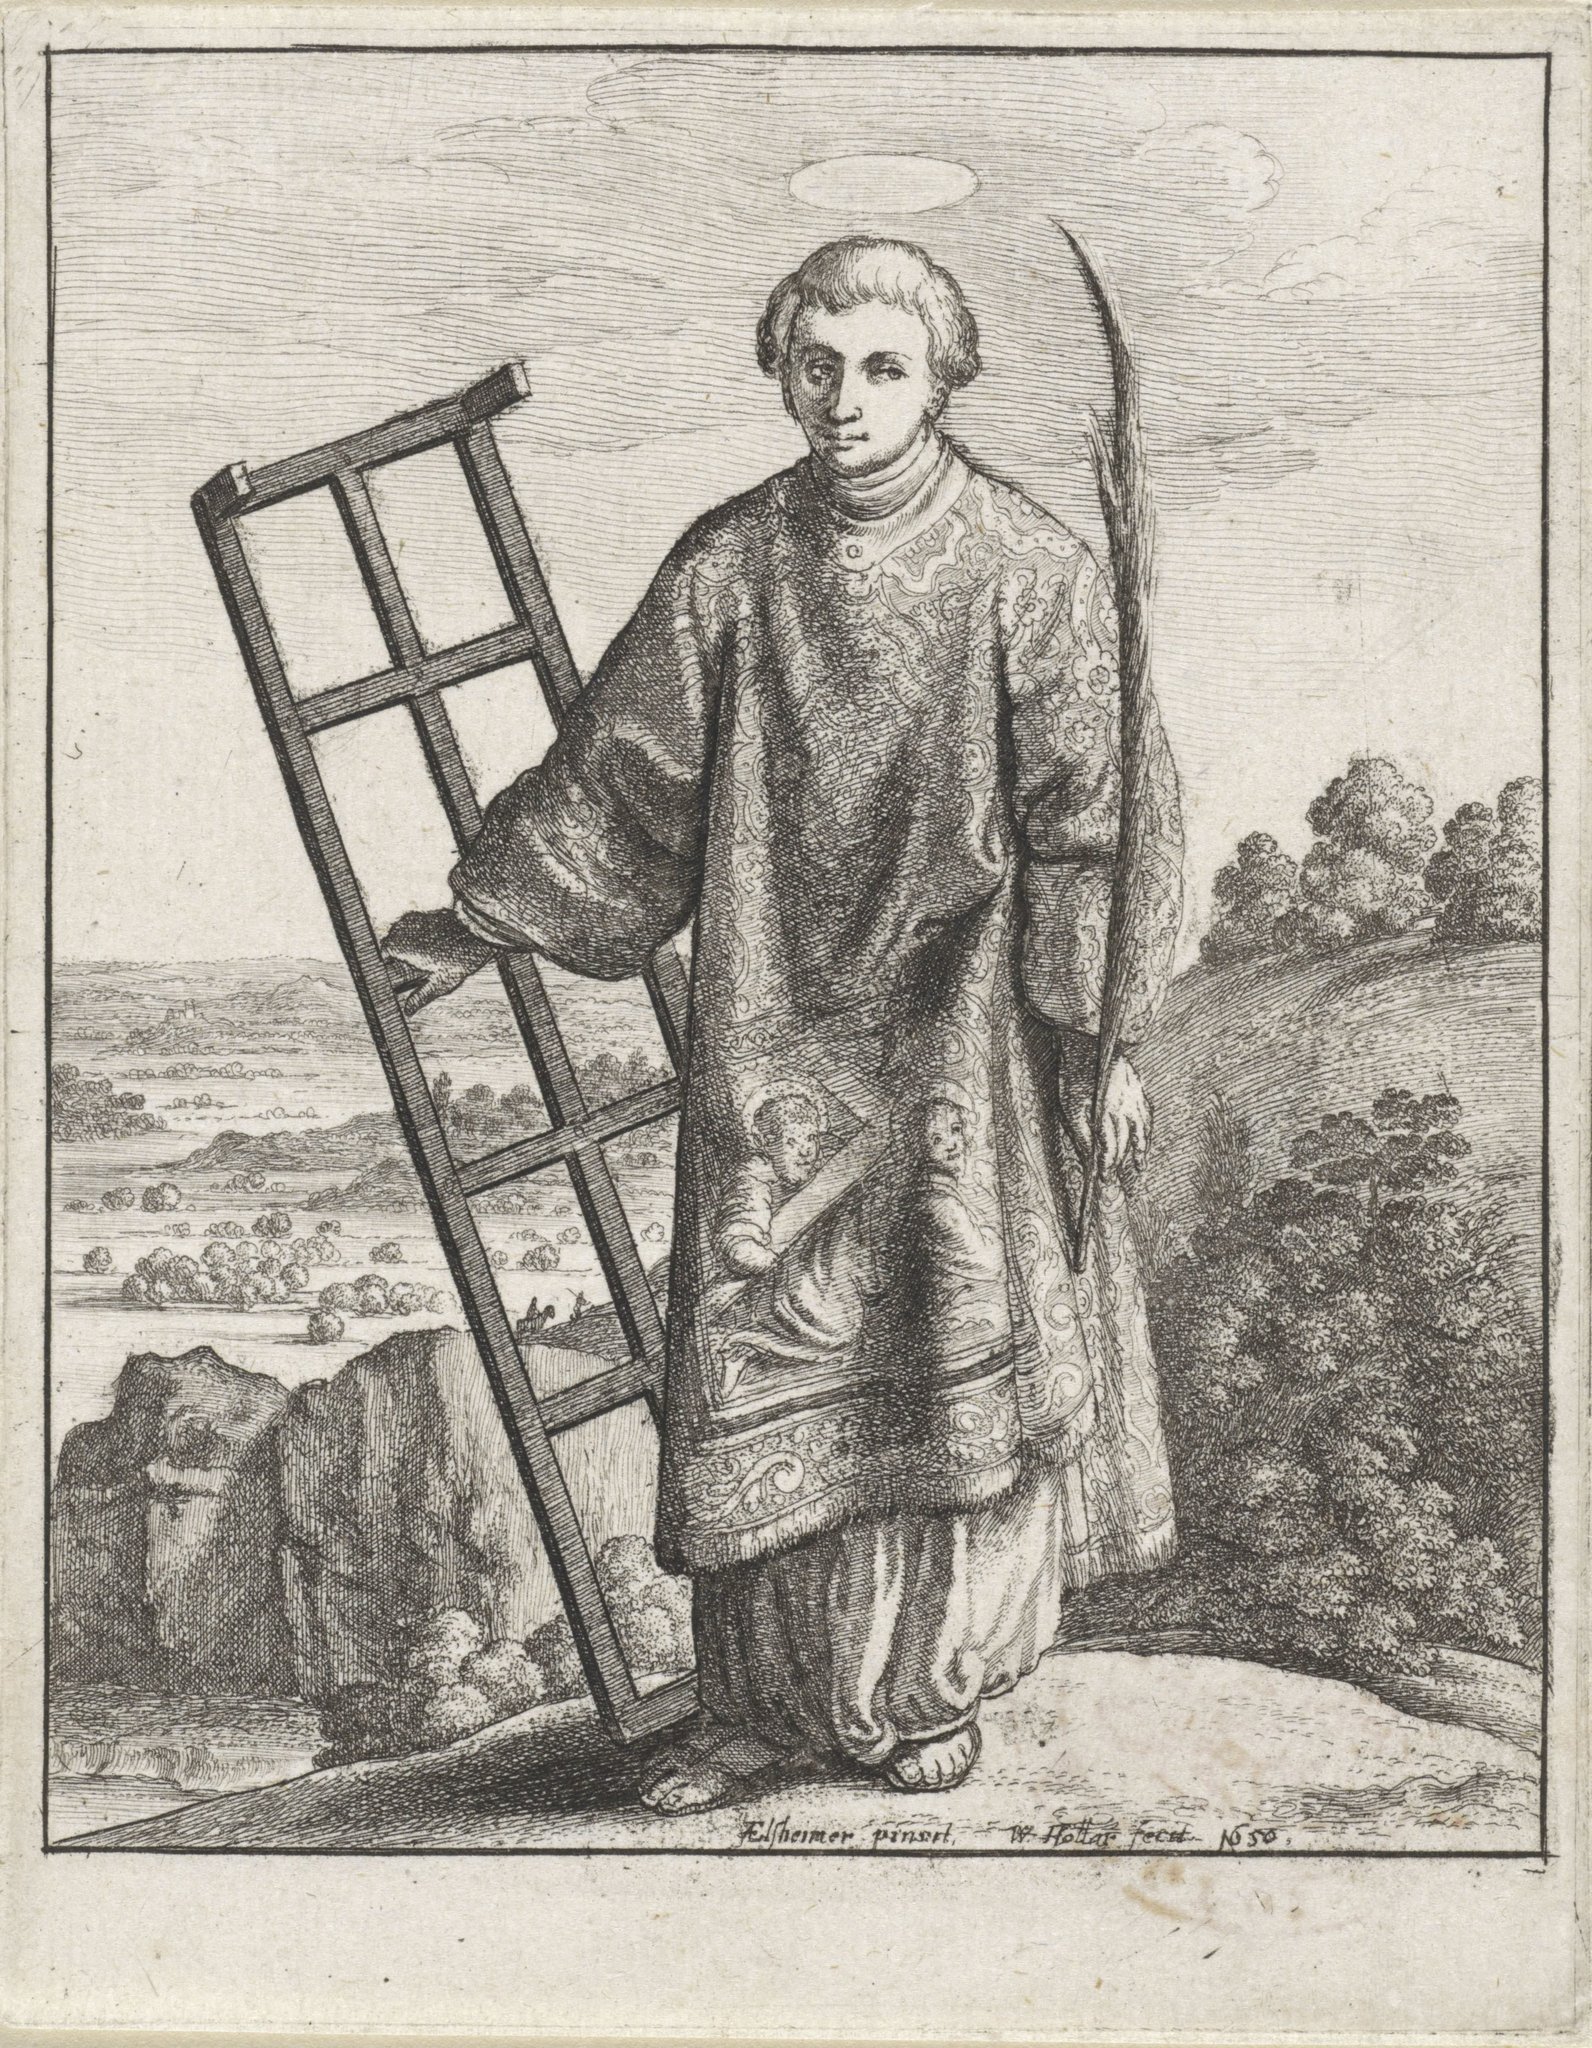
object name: print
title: H. Laurentius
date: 1650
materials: paper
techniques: drypoint, etching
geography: antwerp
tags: the martyr and deacon laurence of rome; possible attributes: book, censer, cross, dalmatic, gridiron, palm, purse (or cup with golden coins)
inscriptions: collector's mark: Lugt 240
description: De heilige Laurentius met rooster in een glooiend landschap.